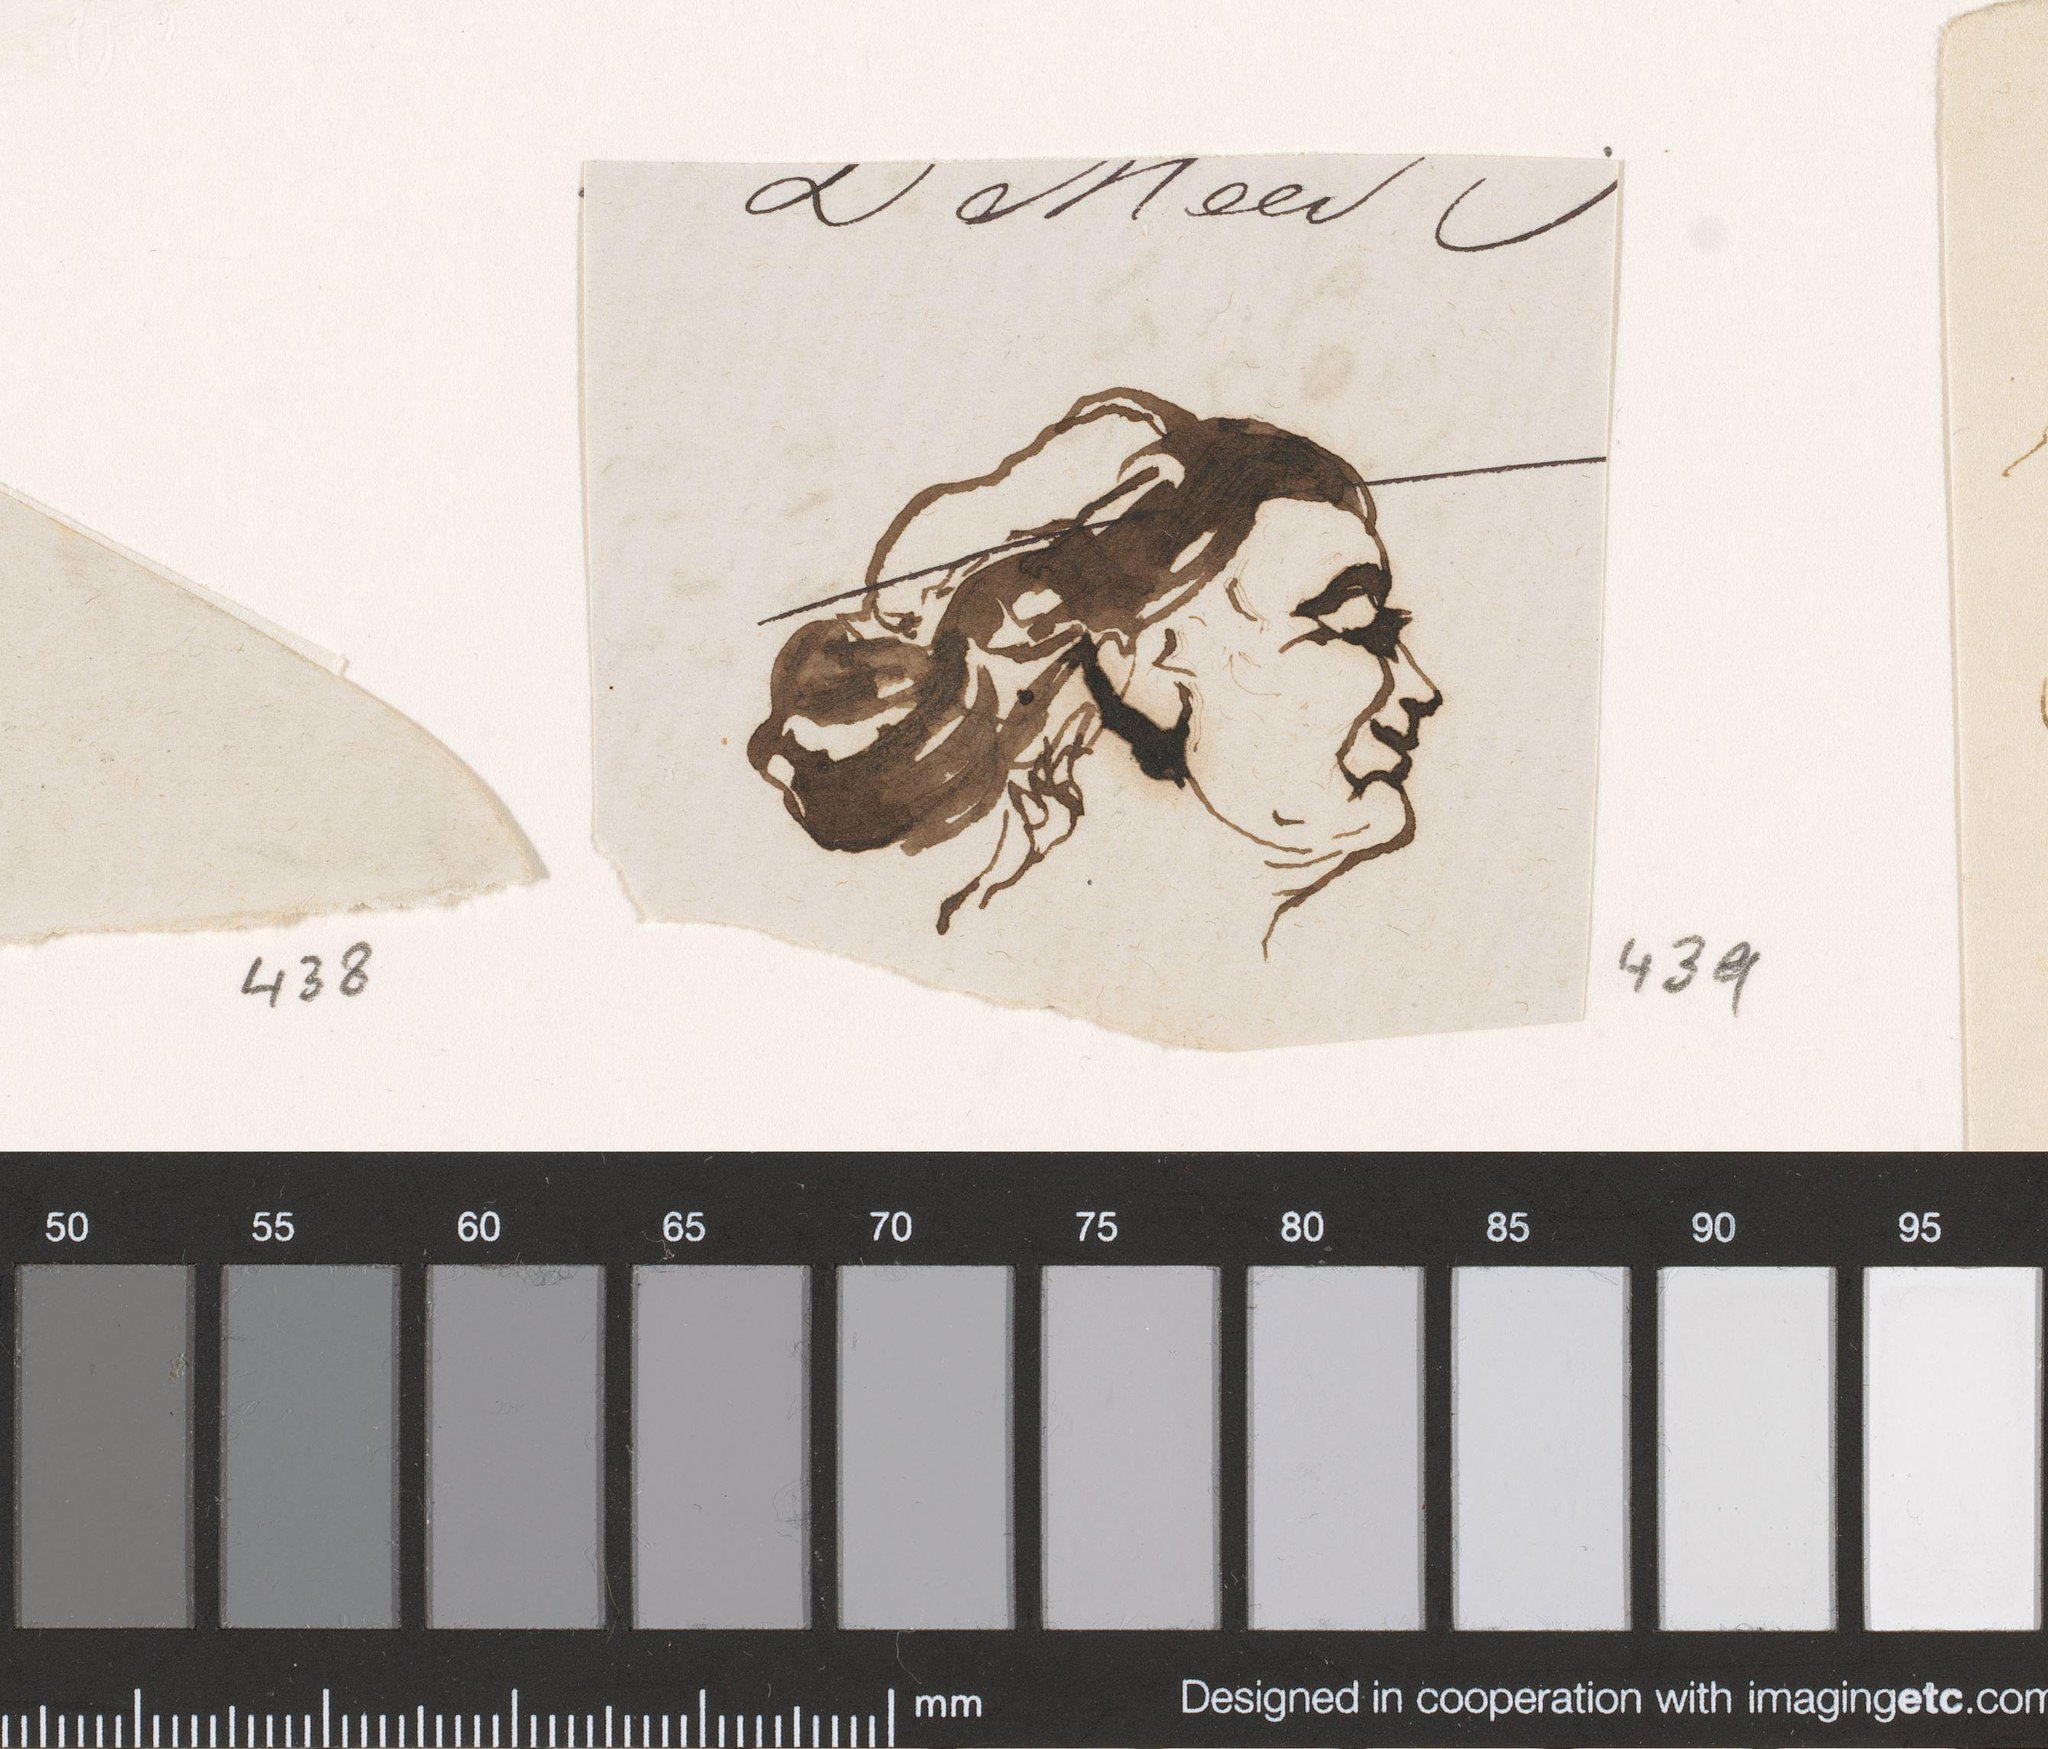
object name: drawing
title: Kop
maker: johannes tavenraat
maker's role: draughtsman, painter, print maker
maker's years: 1809-1881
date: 1840-1880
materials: ink, paper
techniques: pen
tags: caricatures (human types)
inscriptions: collector's mark: Lugt 2228